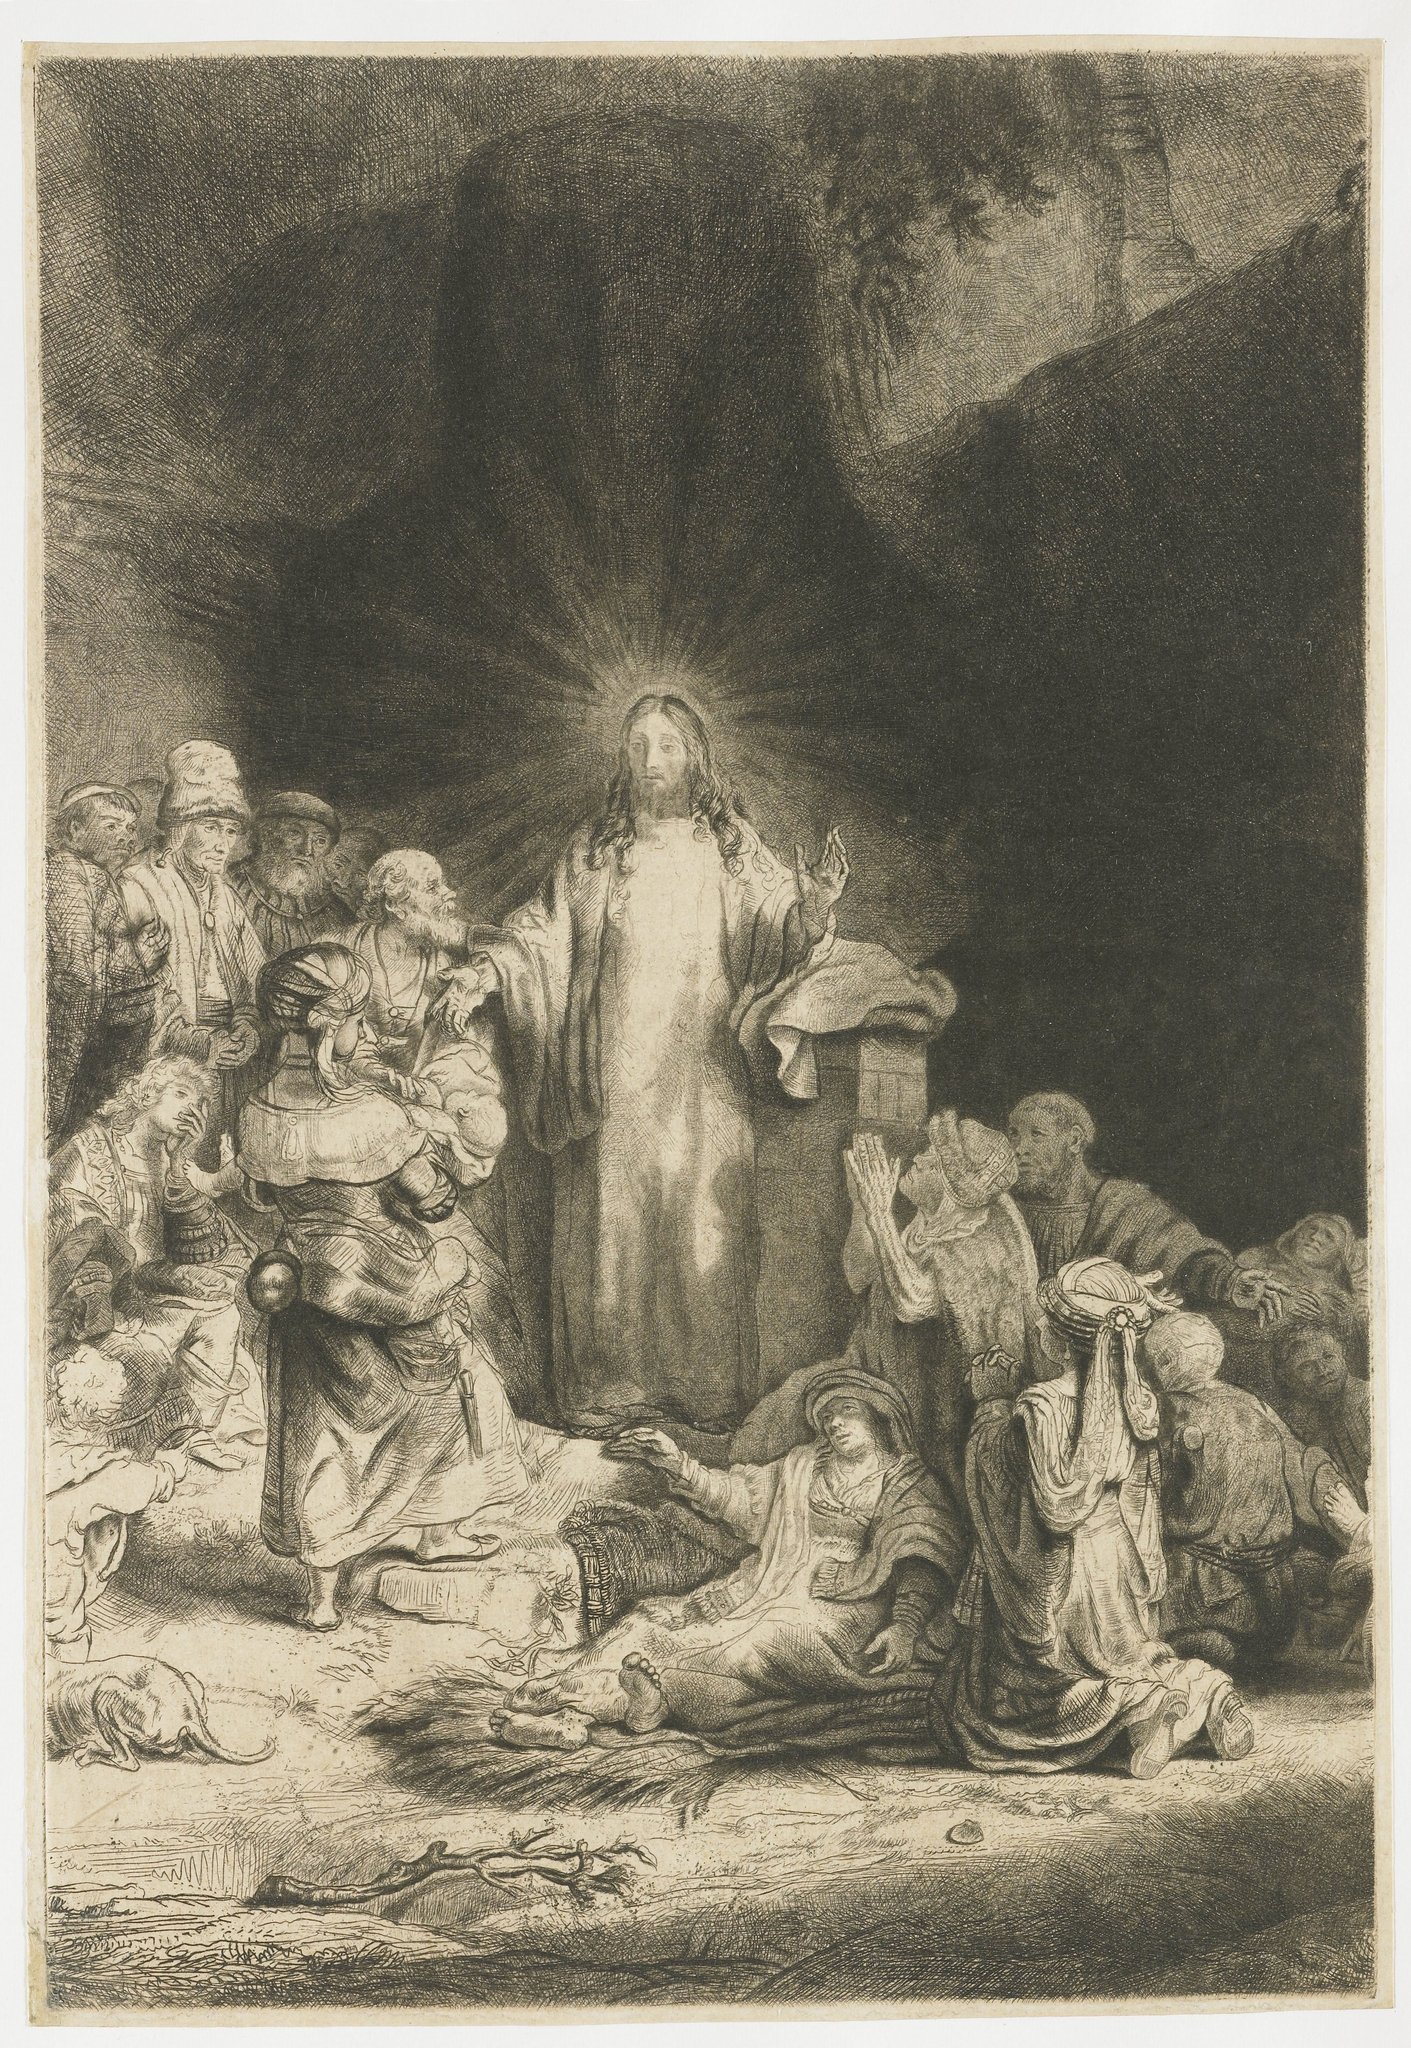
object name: print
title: The Hundred Guilder Print: the central piece with Christ preaching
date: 1775-1800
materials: paper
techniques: drypoint, etching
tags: christ preaching in the open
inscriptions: mark: Lugt 2165